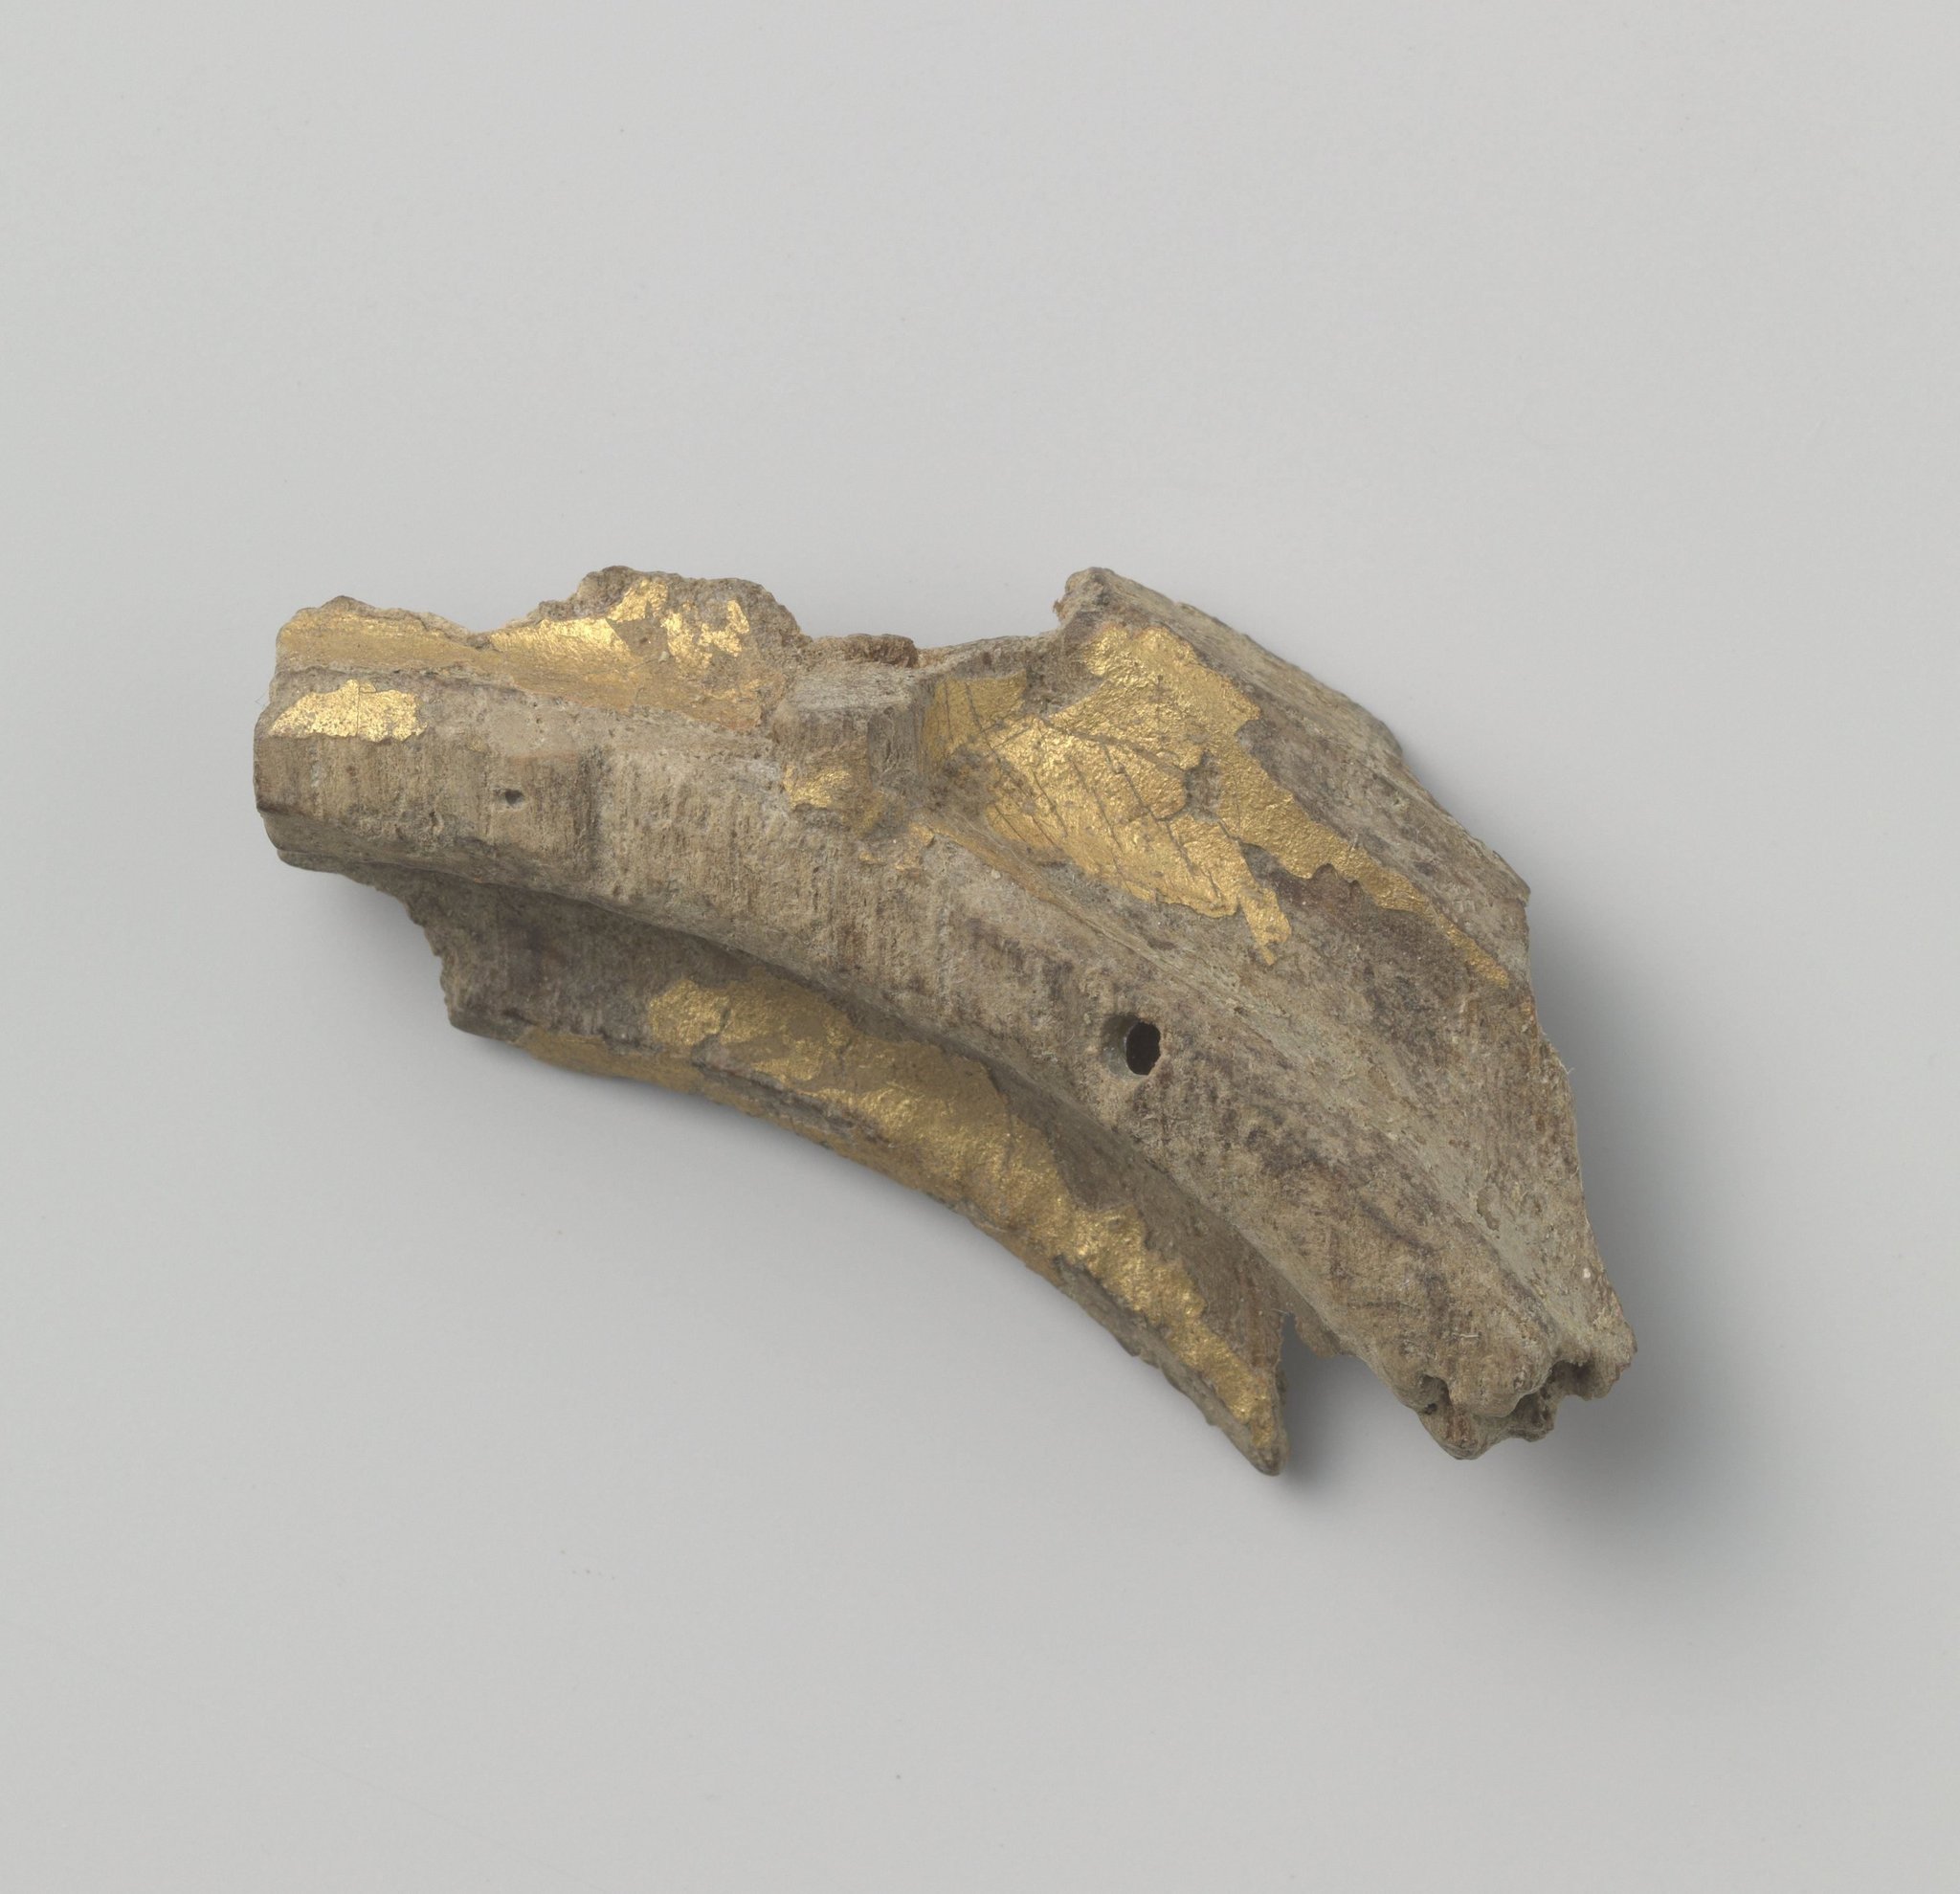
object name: sculpture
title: Fragment; (mogelijk) behorend tot het retabel van Soest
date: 1475-1499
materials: wood